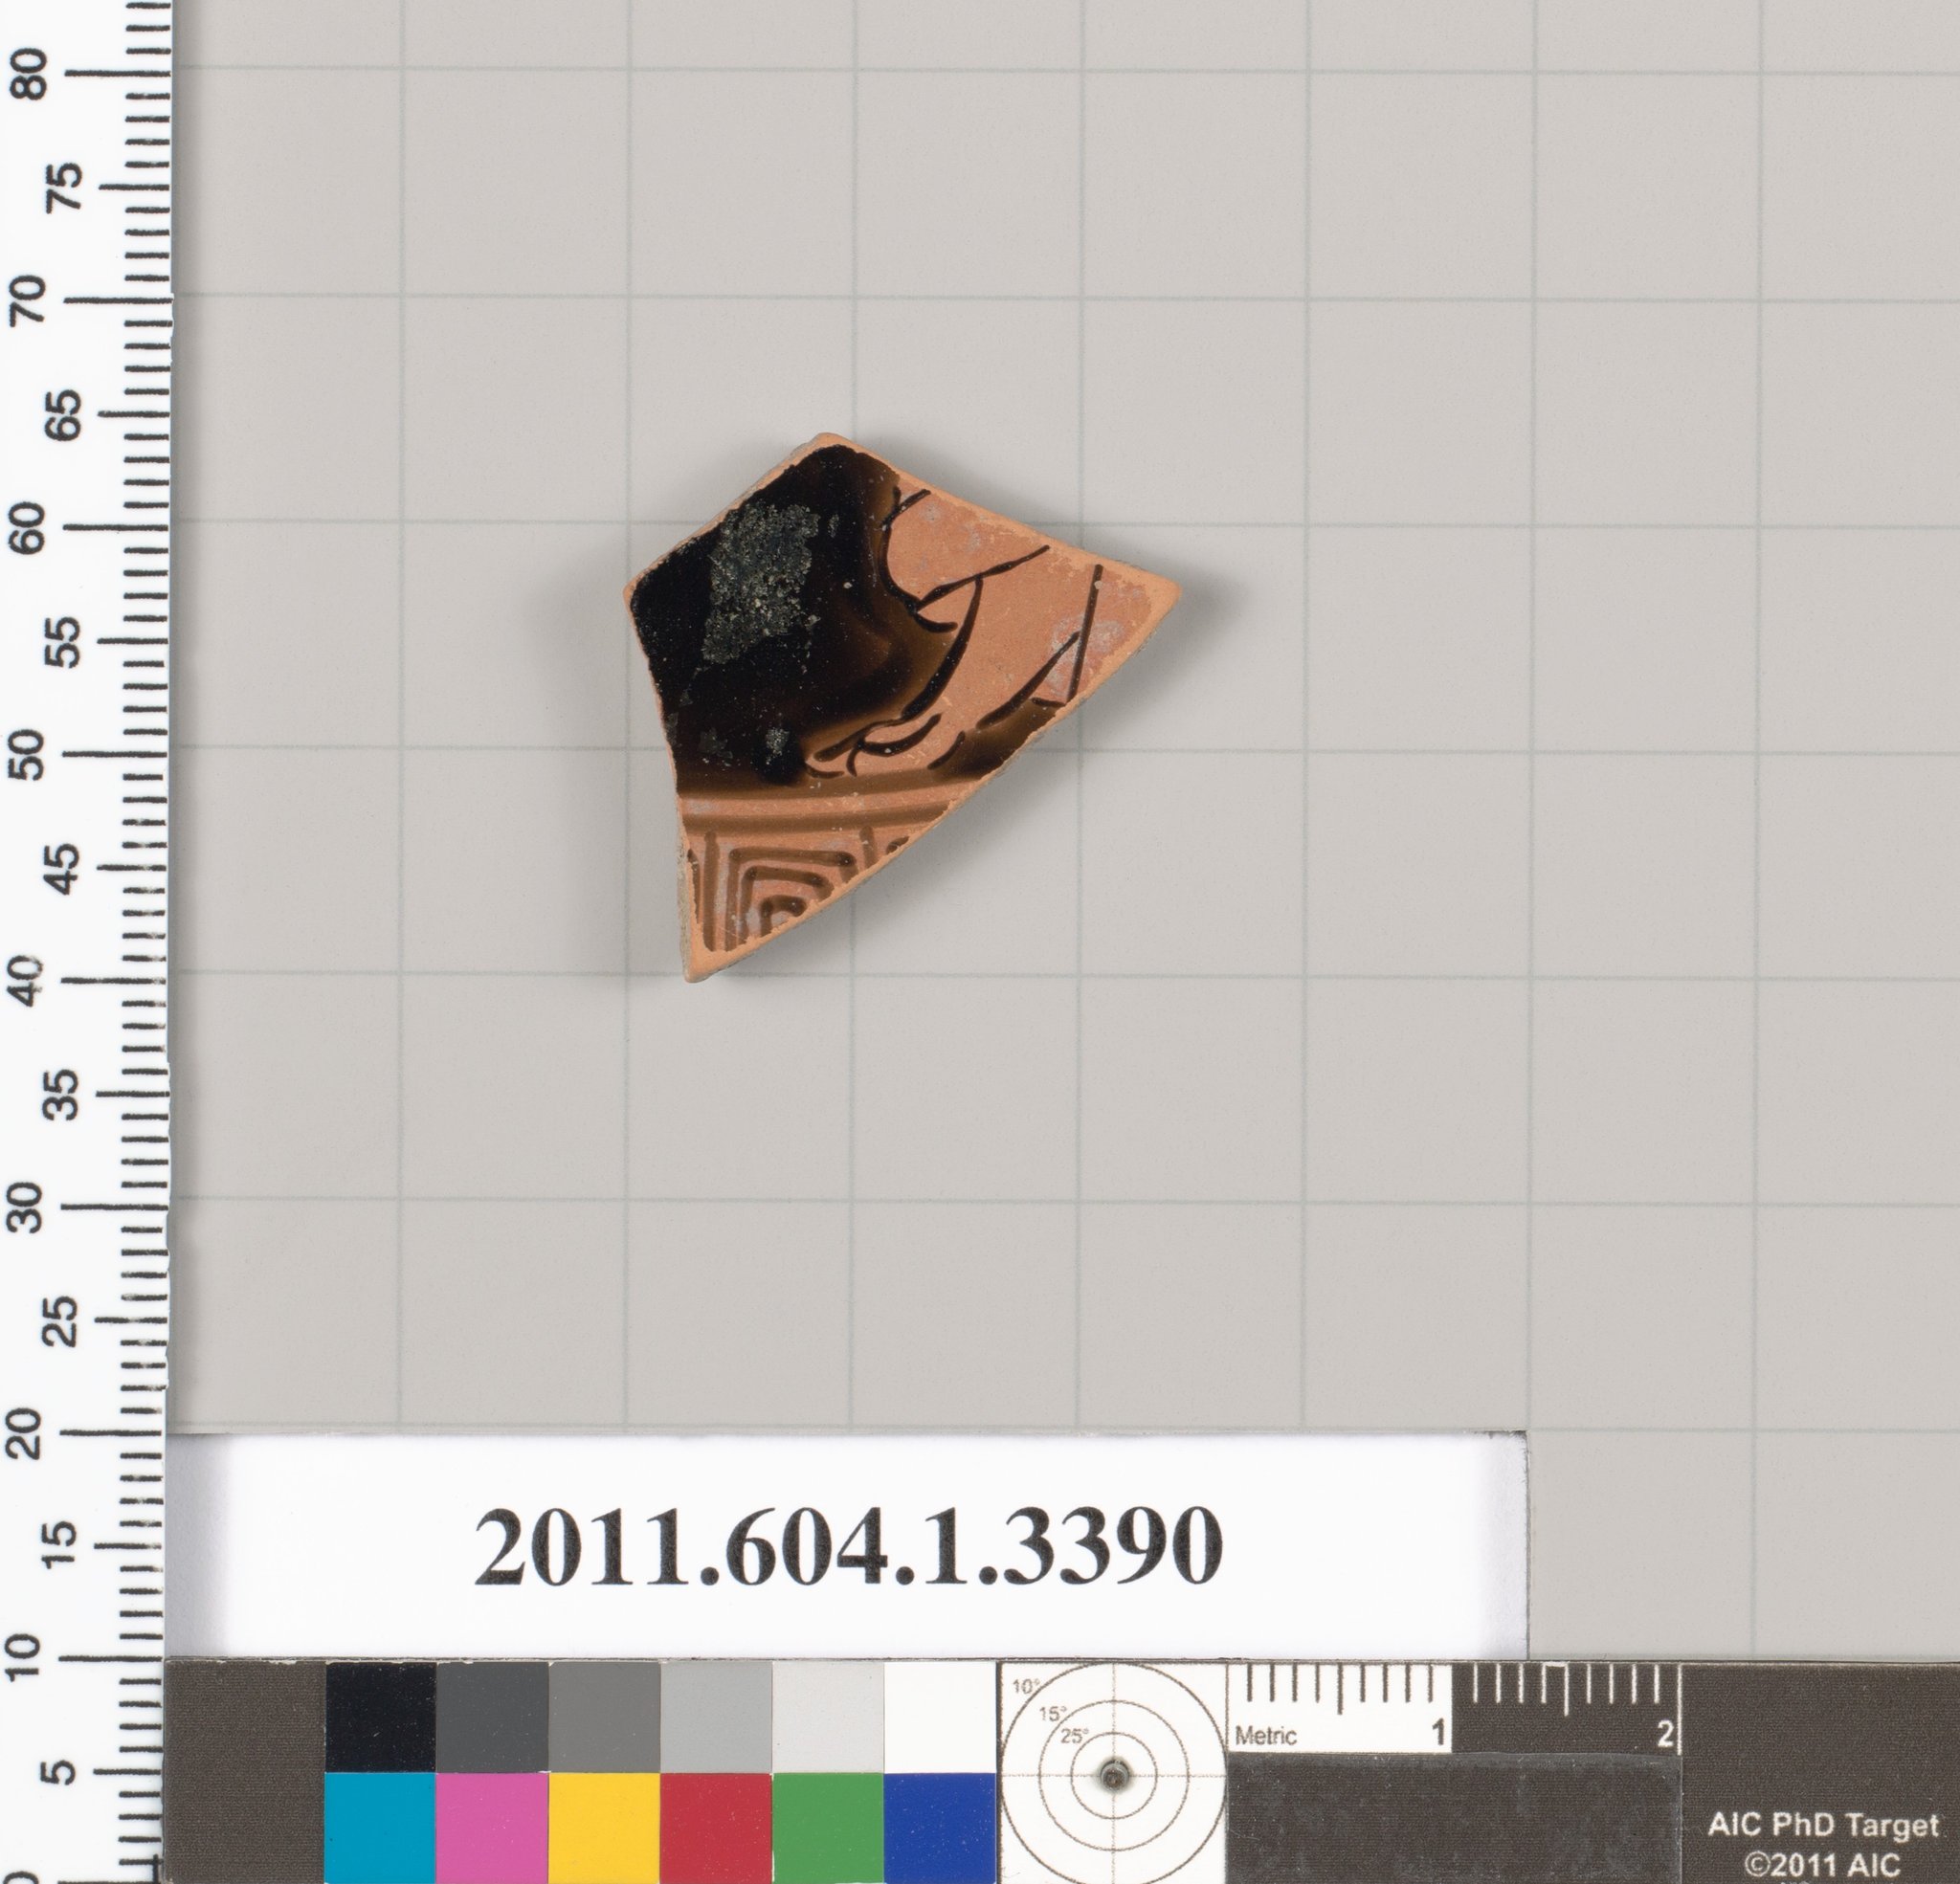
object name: kylix fragment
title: Terracotta fragment of a kylix (drinking cup)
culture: greek, attic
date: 480-470 BCE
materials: terracotta